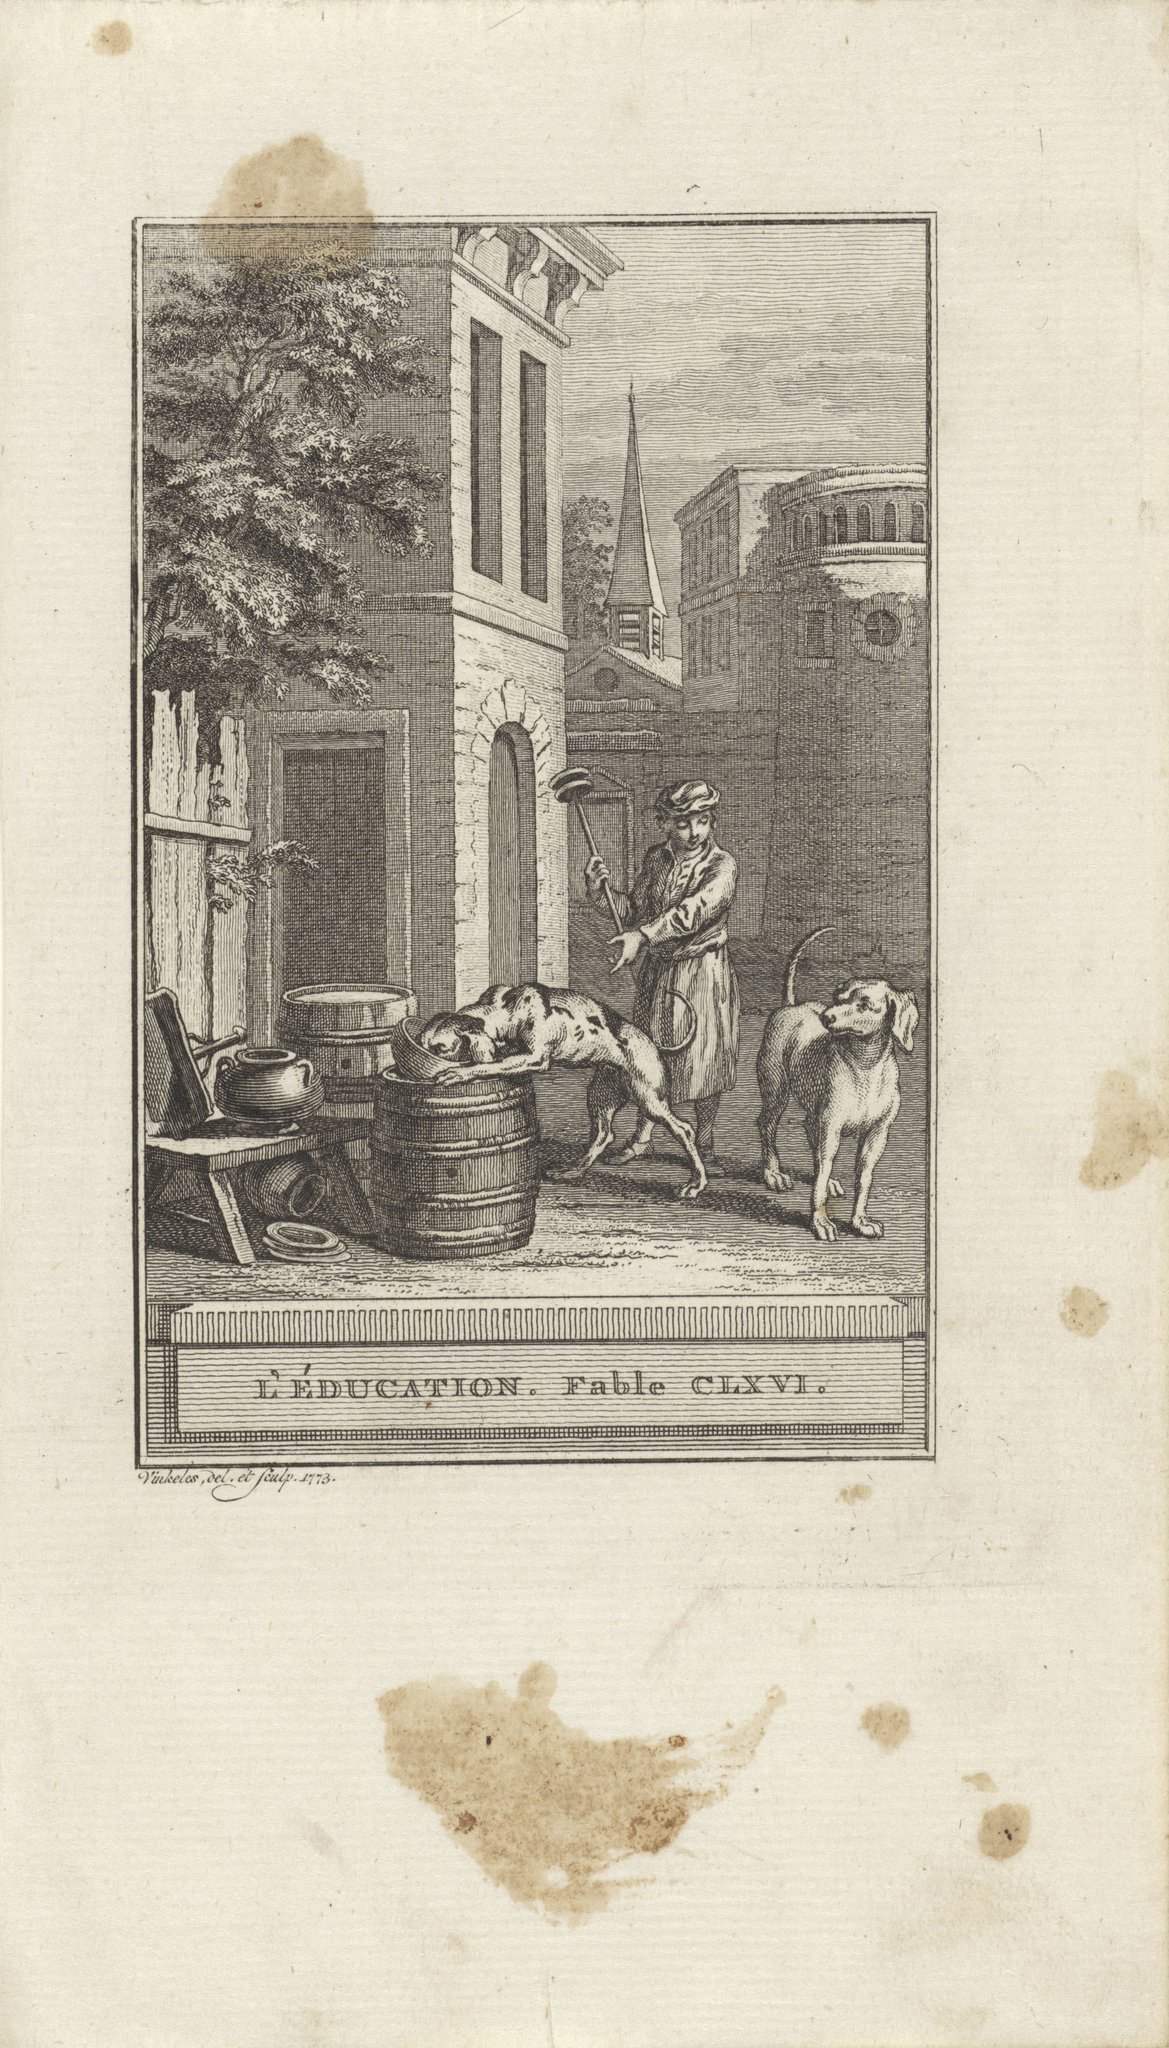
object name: print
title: Opvoeding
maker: reinier vinkeles (i)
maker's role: draughtsman, print maker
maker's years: 1741-1816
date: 1773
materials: paper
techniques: etching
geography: amsterdam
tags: education, index finger forwards, pointing, indicating, dog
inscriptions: collector's mark: Lugt 2228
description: Man en twee honden op een binnenplaats. De man lijkt een van de honden iets duidelijk te willen maken door met zijn hand te wijzen op de andere hond. Illustratie van Fabel CLXVI, L'éducation.